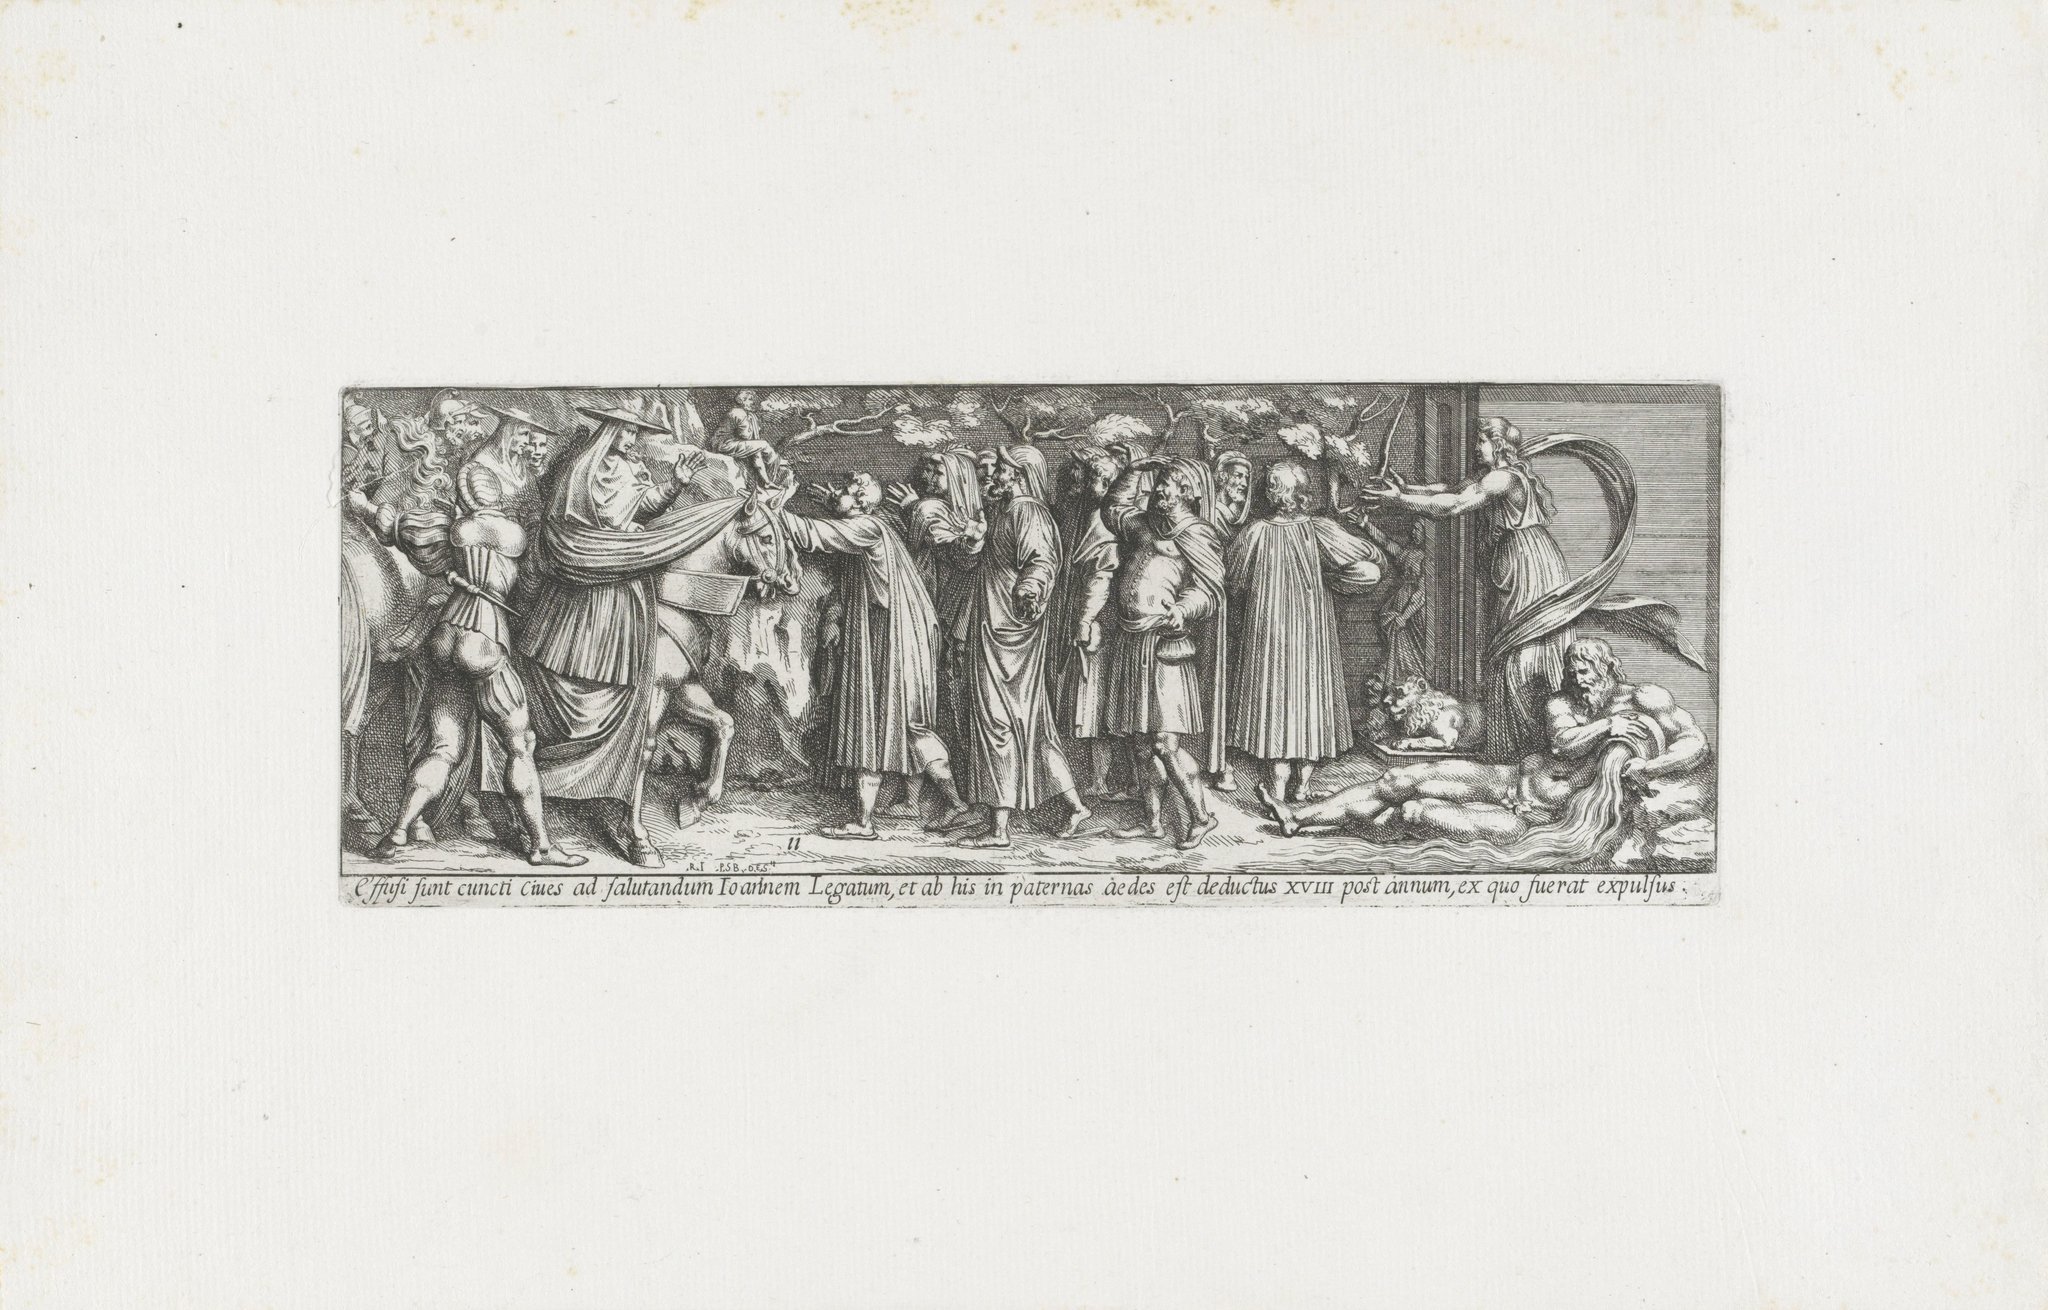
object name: print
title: Scènes uit het leven van paus Leo X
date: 1645-1700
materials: paper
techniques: engraving, etching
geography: italy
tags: rome, leo x, arrival and return ~ travelling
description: Giovanni de' Medici gaat met zijn leger Florence binnen en wordt verwelkomd door een groep Florentijnen. Rechts een liggende riviergod. Titel in ondermarge. Genummerd midden onder: 11.